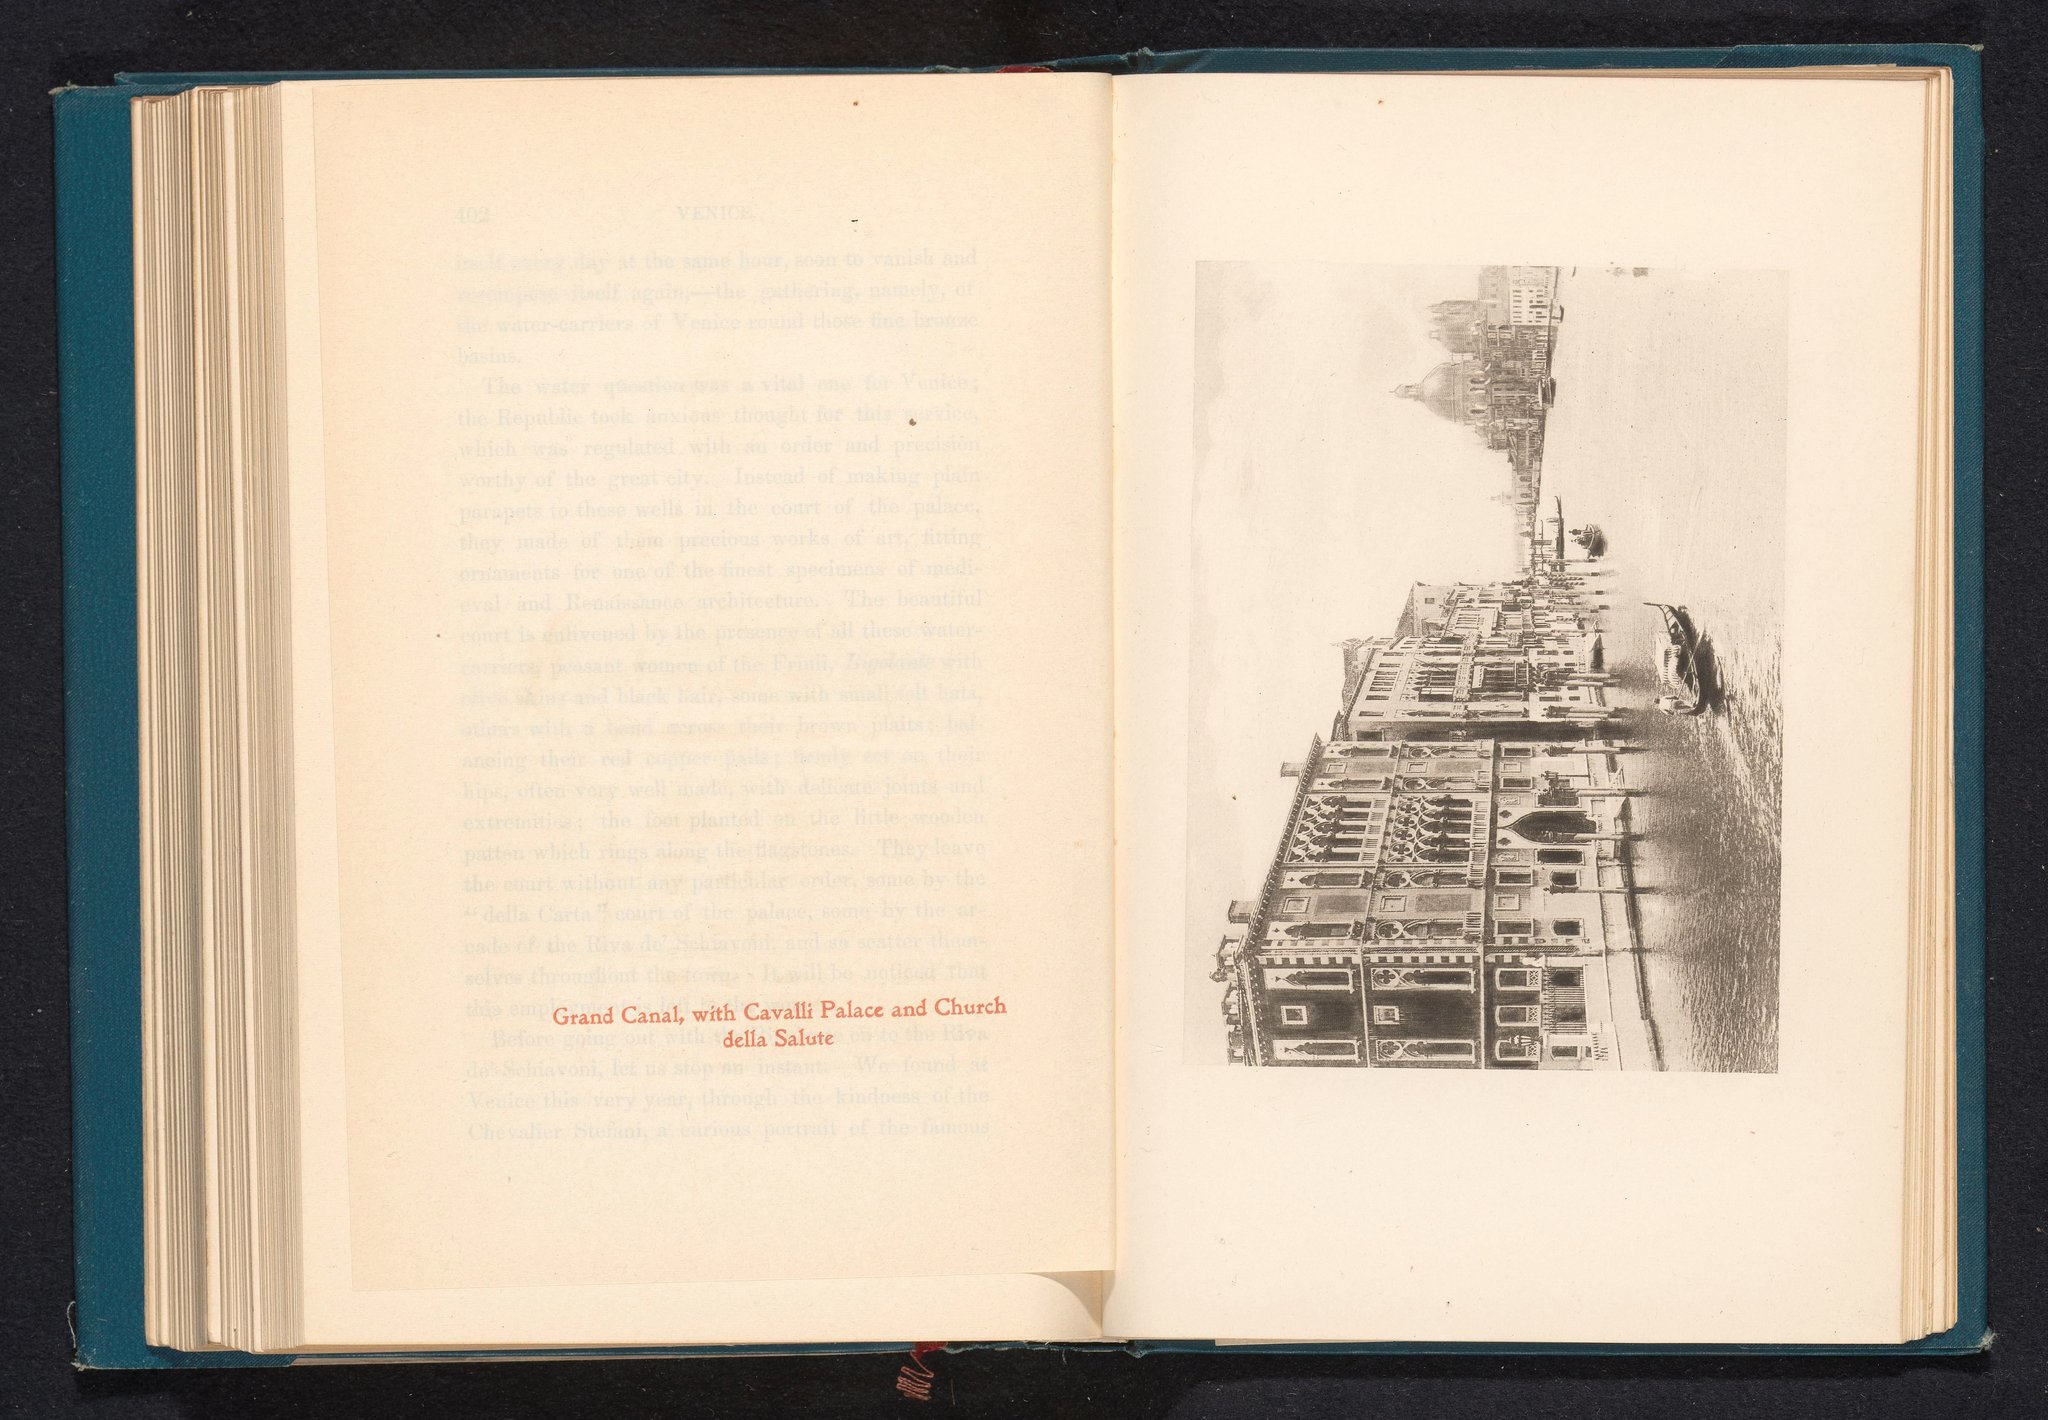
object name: photomechanical print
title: Gezicht op het Canal Grande te Venetië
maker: Anonymous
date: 1882-1892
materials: paper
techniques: photoaquatint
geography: venice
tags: canals, waters (in city)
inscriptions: title: ‘Grand Canal, with Cavalli Palace and Church della Salute’